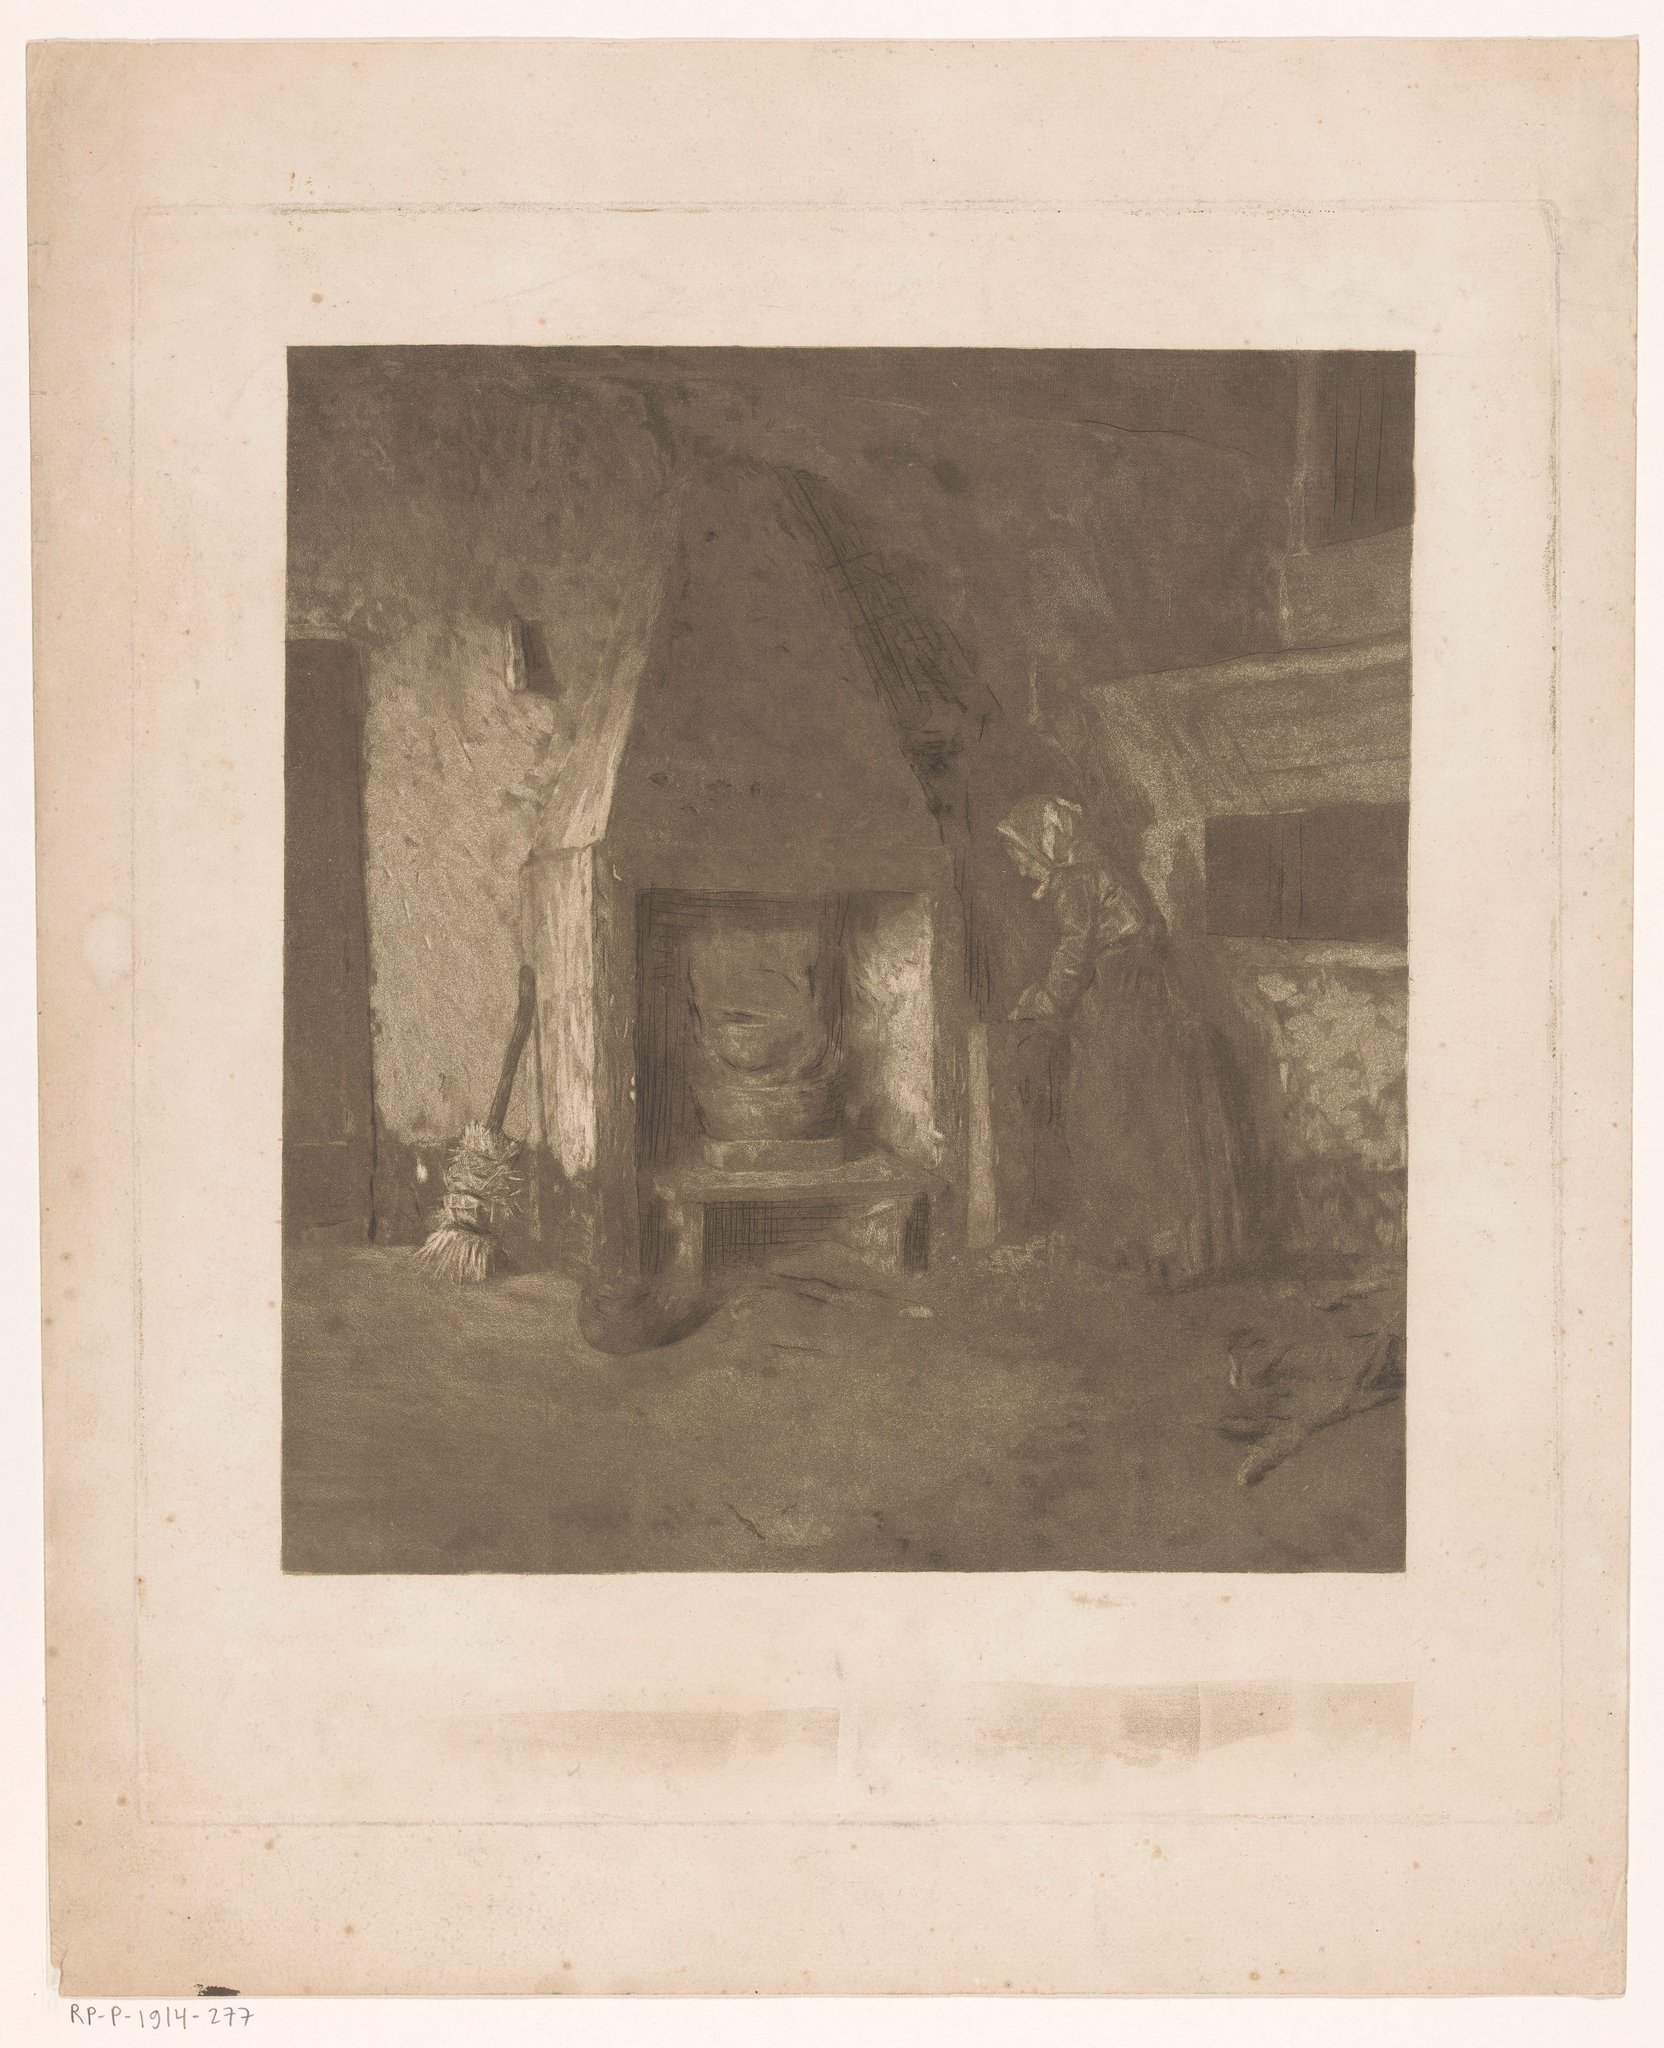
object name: print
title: Boerenvrouw staand bij een haard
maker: emanuel samson van beever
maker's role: draughtsman, painter, print maker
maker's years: 1876-1912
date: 1886-1912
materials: paper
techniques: aquatint, etching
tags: open hearth, fire-place, farm (building) - aa - civic architecture: inside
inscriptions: collector's mark: Lugt 2233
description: De vrouw draagt een hoofddoek. Tegen de haard leunt een bezem.